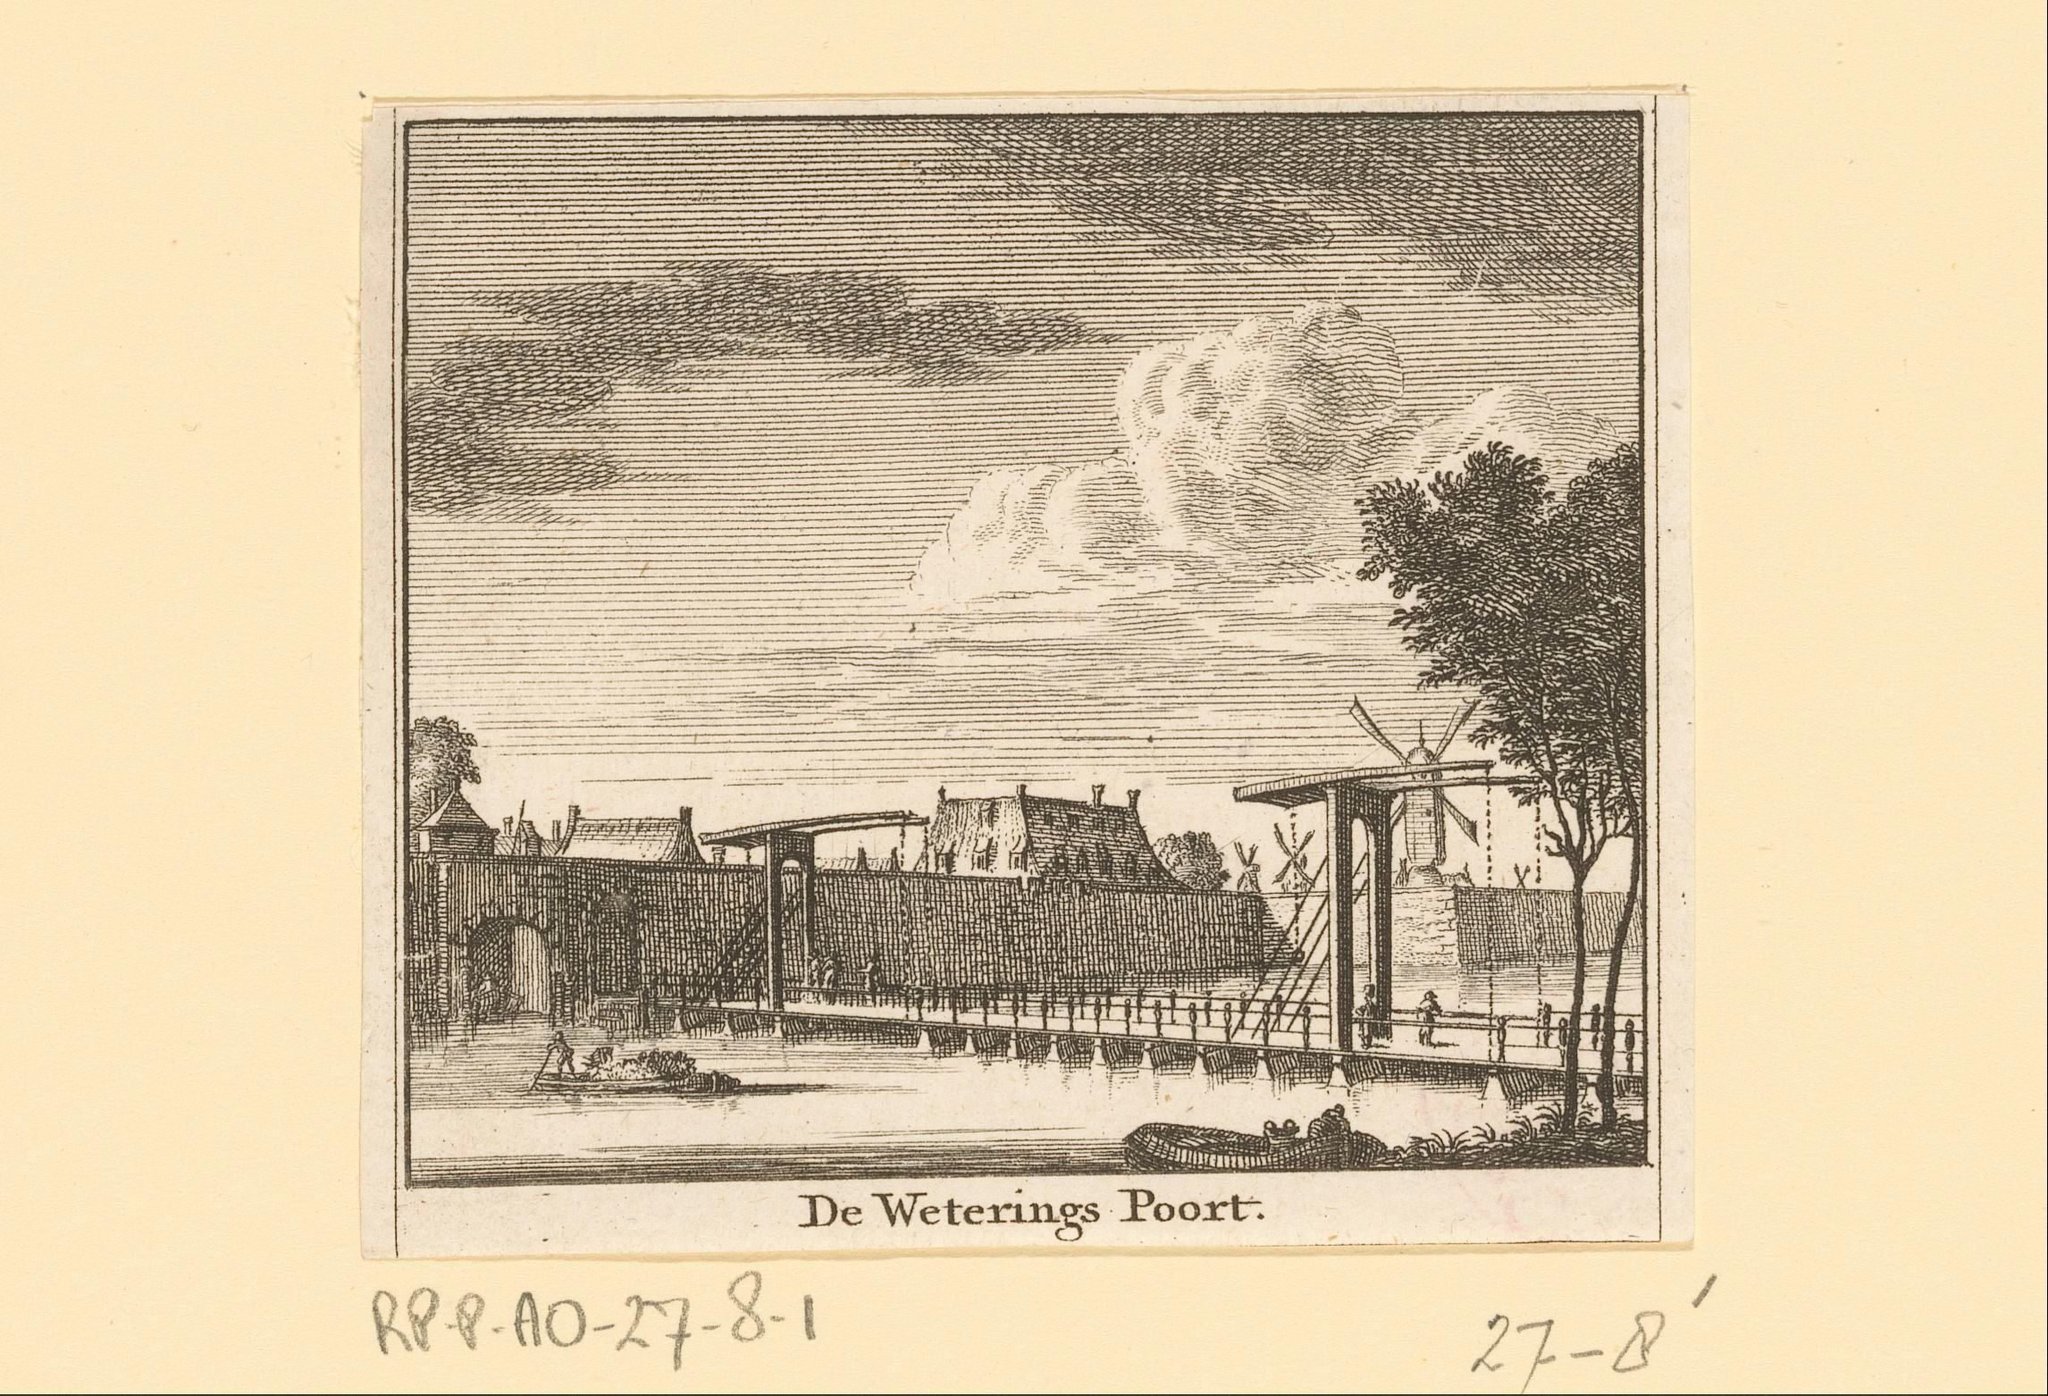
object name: book illustration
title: De Weterings Poort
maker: jan goeree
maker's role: draughtsman, print maker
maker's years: 1670-1731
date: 1723-1738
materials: paper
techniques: engraving, etching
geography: amsterdam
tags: bridge, city-gate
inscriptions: collector's mark: Lugt 195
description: Prent ook gebruikt in: Willink, Daniël. Amsterdamsche Buitensingel nevens de omleggende dorpen, opgeheldert door aanteekeningen over veele voornaame geschiedeniszen: met afbeeldingen (…) / Daniël Willinks Amsterdamsche Buitensingel. Amsterdam: Andries van Damme, 1723. En in: Willink, Daniël. Amsterdamsche Buitensingel nevens de omleggende dorpen, opgeheldert door aanteekeningen over veele voornaame geschiedenissen: met afbeeldingen (…) / Daniël Willinks Amsterdamsche Buitensingel. Amsterdam: Arend van Huyssteen, 1738. Zie ook RP-P-1911-3006 en RP-P-AO-24X-40.